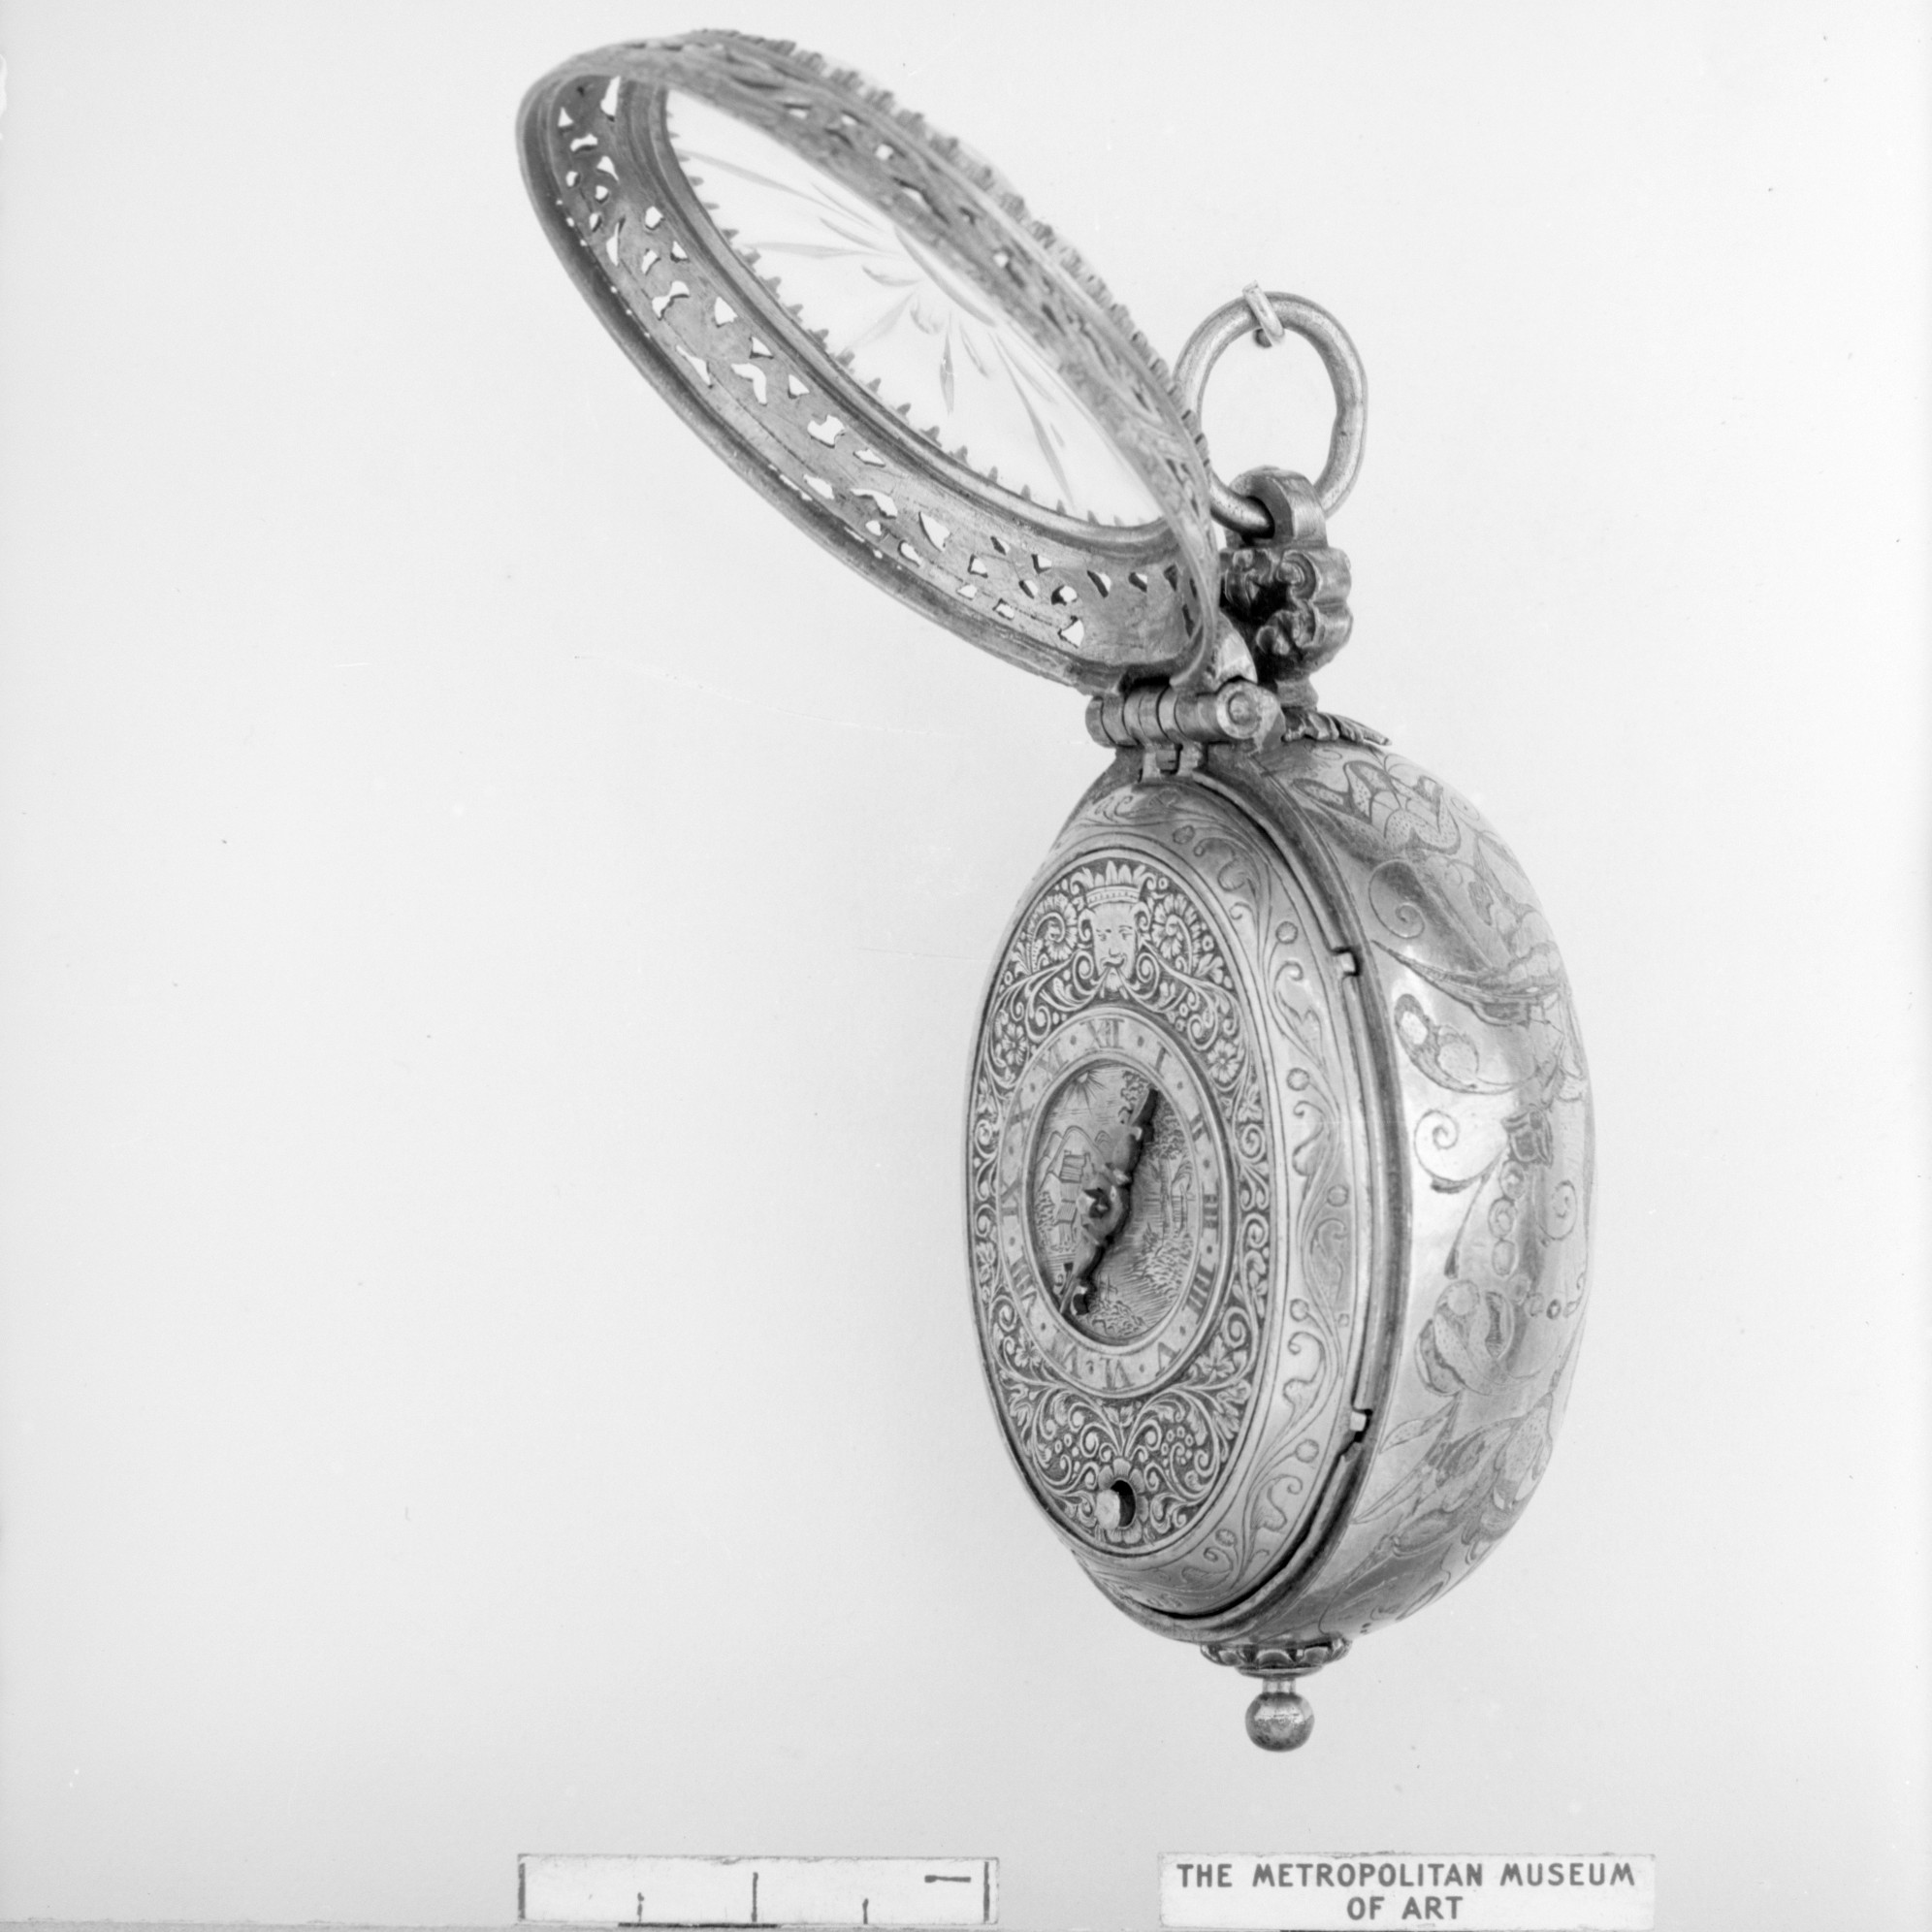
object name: watch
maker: david buschman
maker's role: maker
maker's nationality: german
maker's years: 1626-1701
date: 1640-1660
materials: gilt, metal, quartz, silver